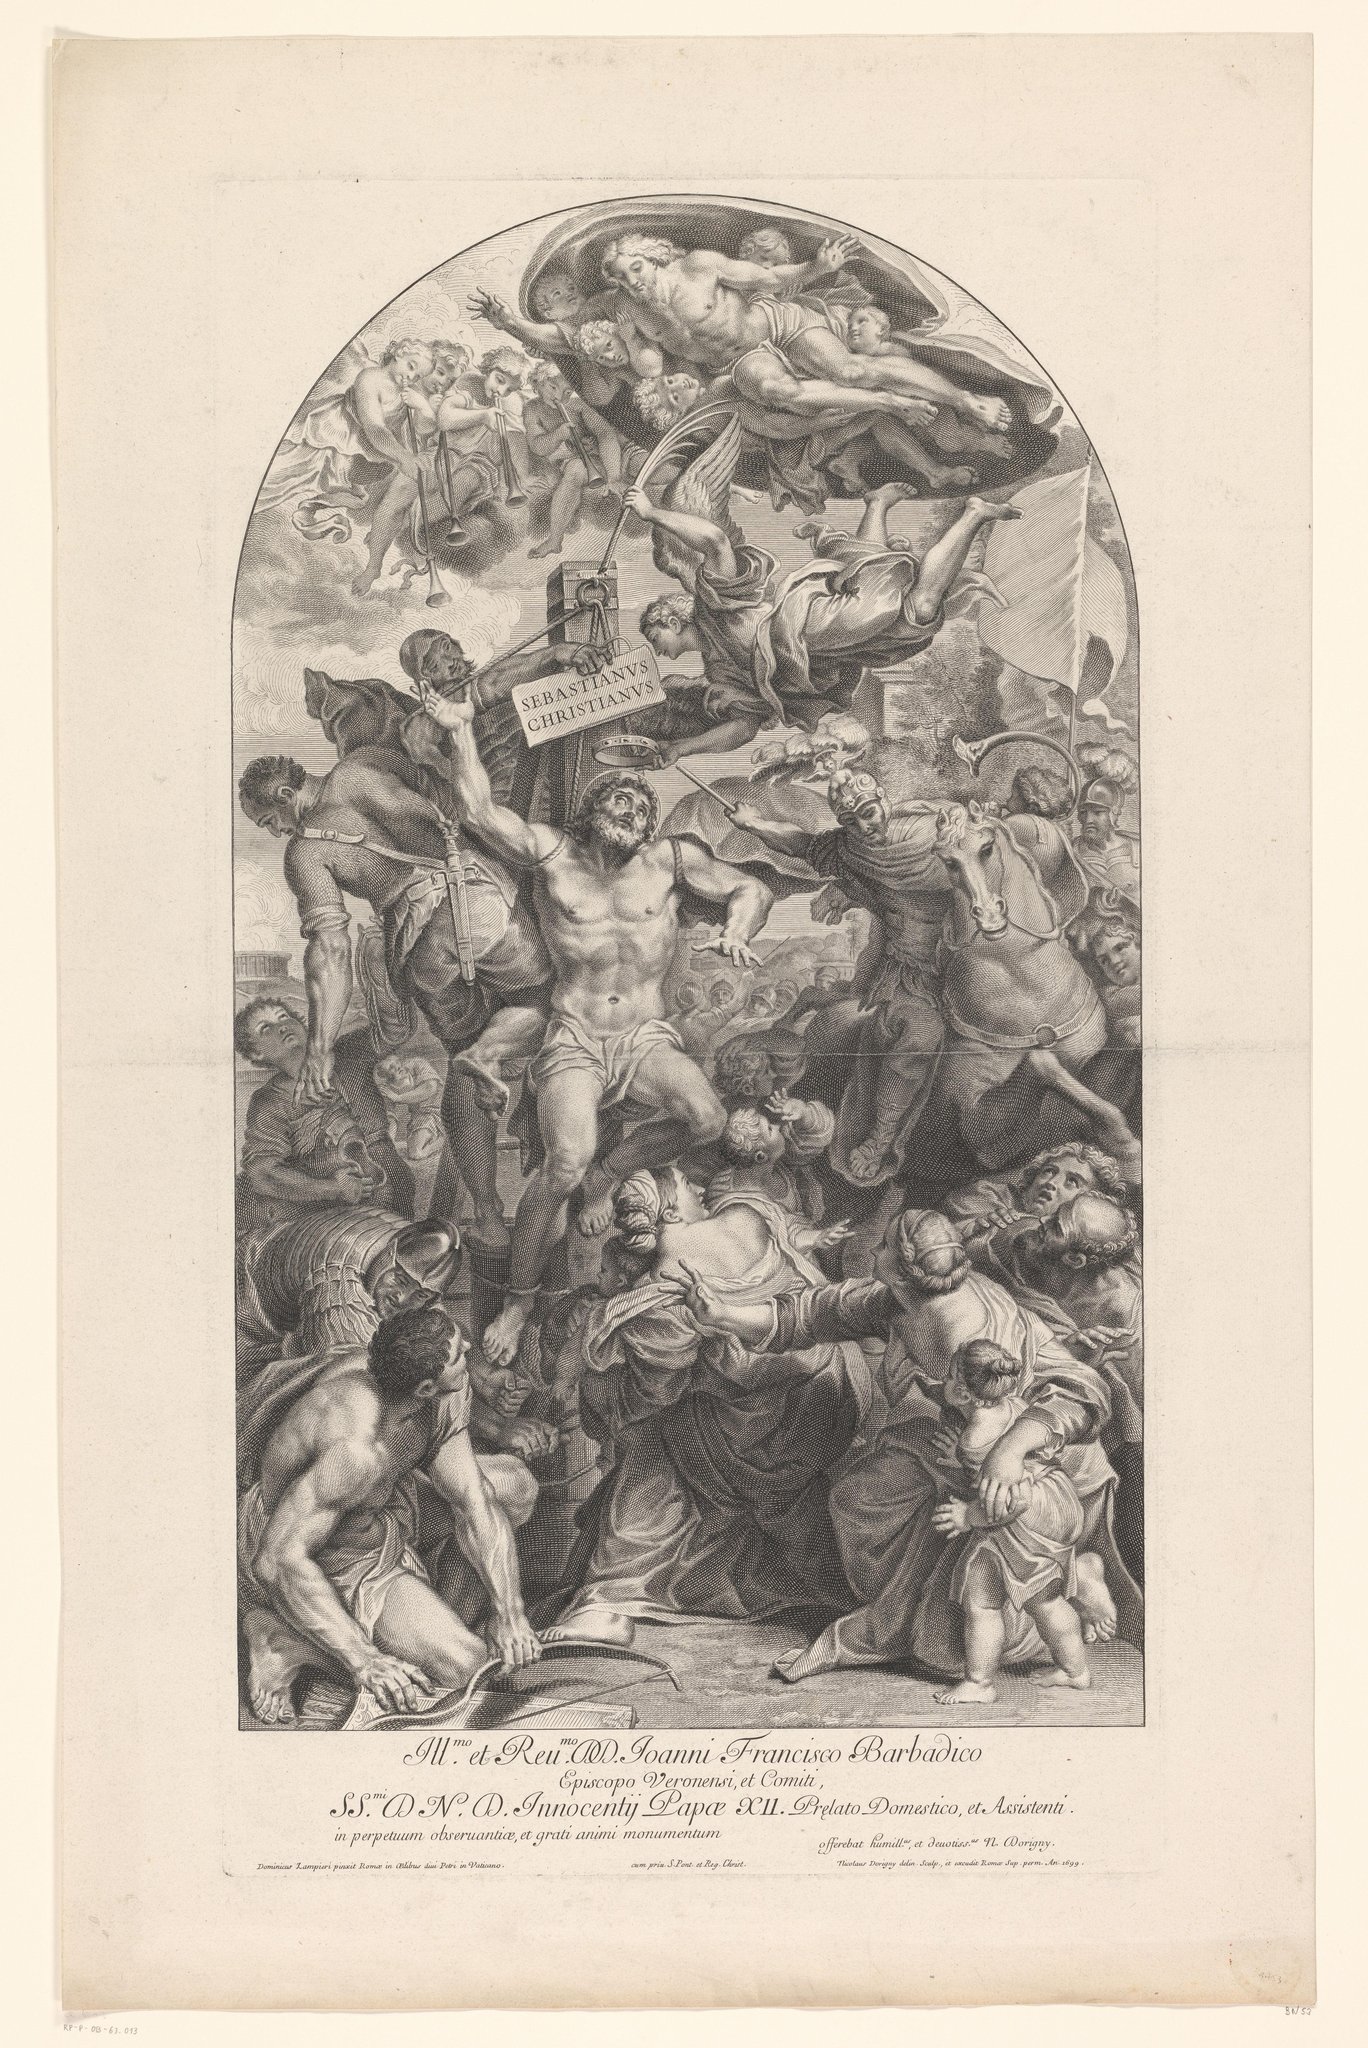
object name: print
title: Martelaarschap van H. Sebastiaan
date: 1699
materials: paper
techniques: engraving, etching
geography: rome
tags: martyrdom, suffering, misfortune, death of st. sebastian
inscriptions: collector's mark: Lugt 240